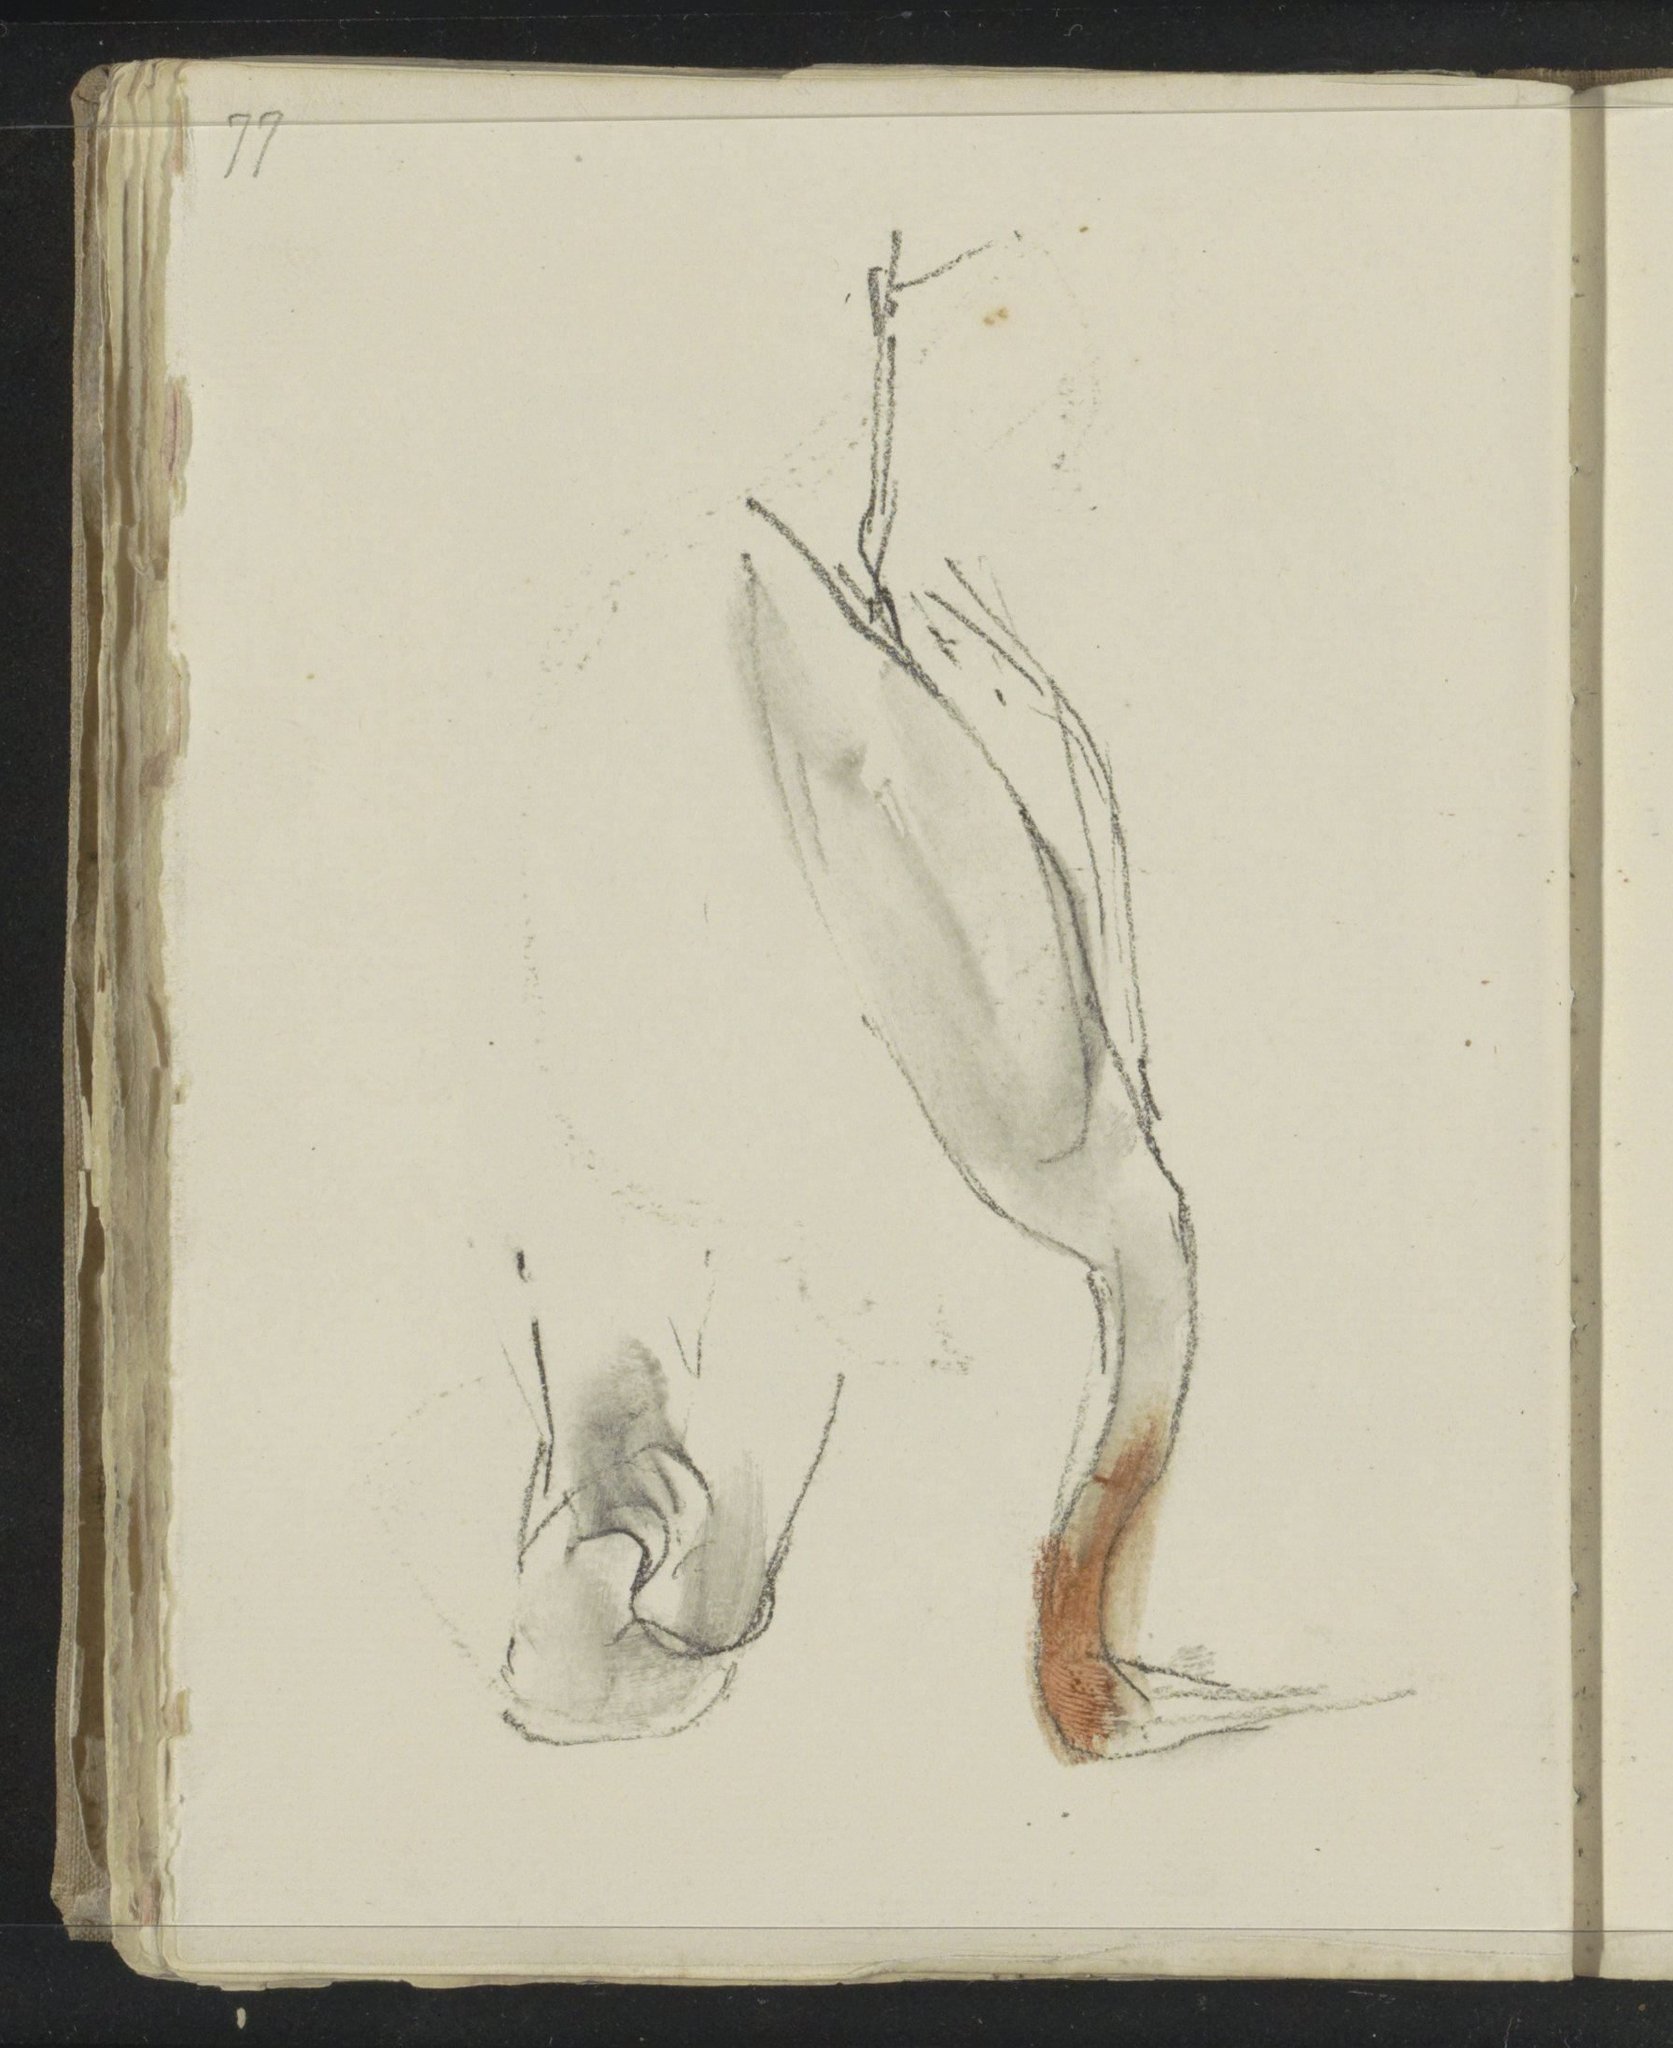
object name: sketchbook leaf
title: Vogel, mogelijk een reiger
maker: floris arntzenius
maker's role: draughtsman, print maker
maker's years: 1864-1925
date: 1883-1914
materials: chalk, paper, watercolor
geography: the hague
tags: shore-birds and wading-birds: stork, shore-birds and wading-birds: heron, water-birds: duck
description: Ook mogelijk een kop van een eend. Pagina 77 uit een schetsboek met 82 pagina's.